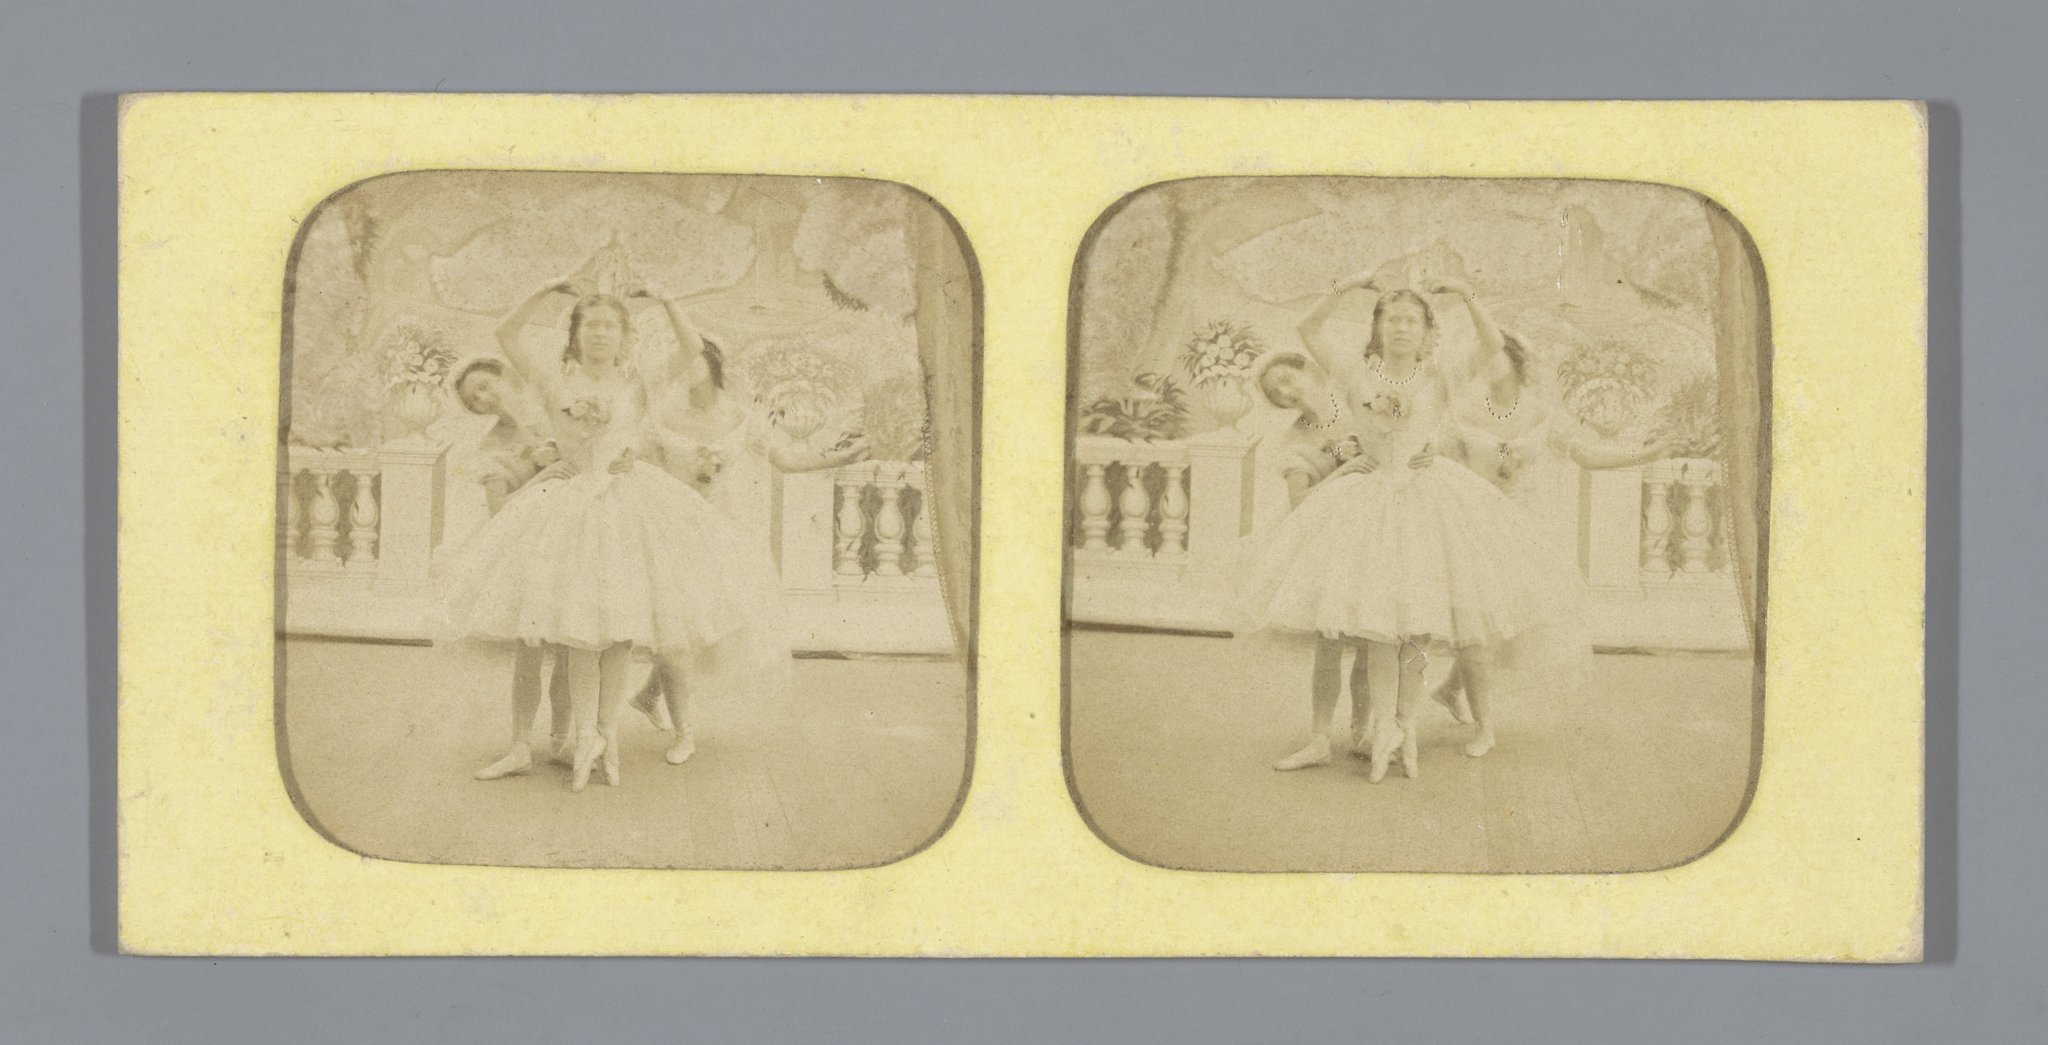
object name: tissue stereograph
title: Drie ballet dansende vrouwen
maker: Anonymous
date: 1855-1875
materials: cardboard, paper, photographic support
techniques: albumen print, hand coloring, perforating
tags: the ballet, ballet performance